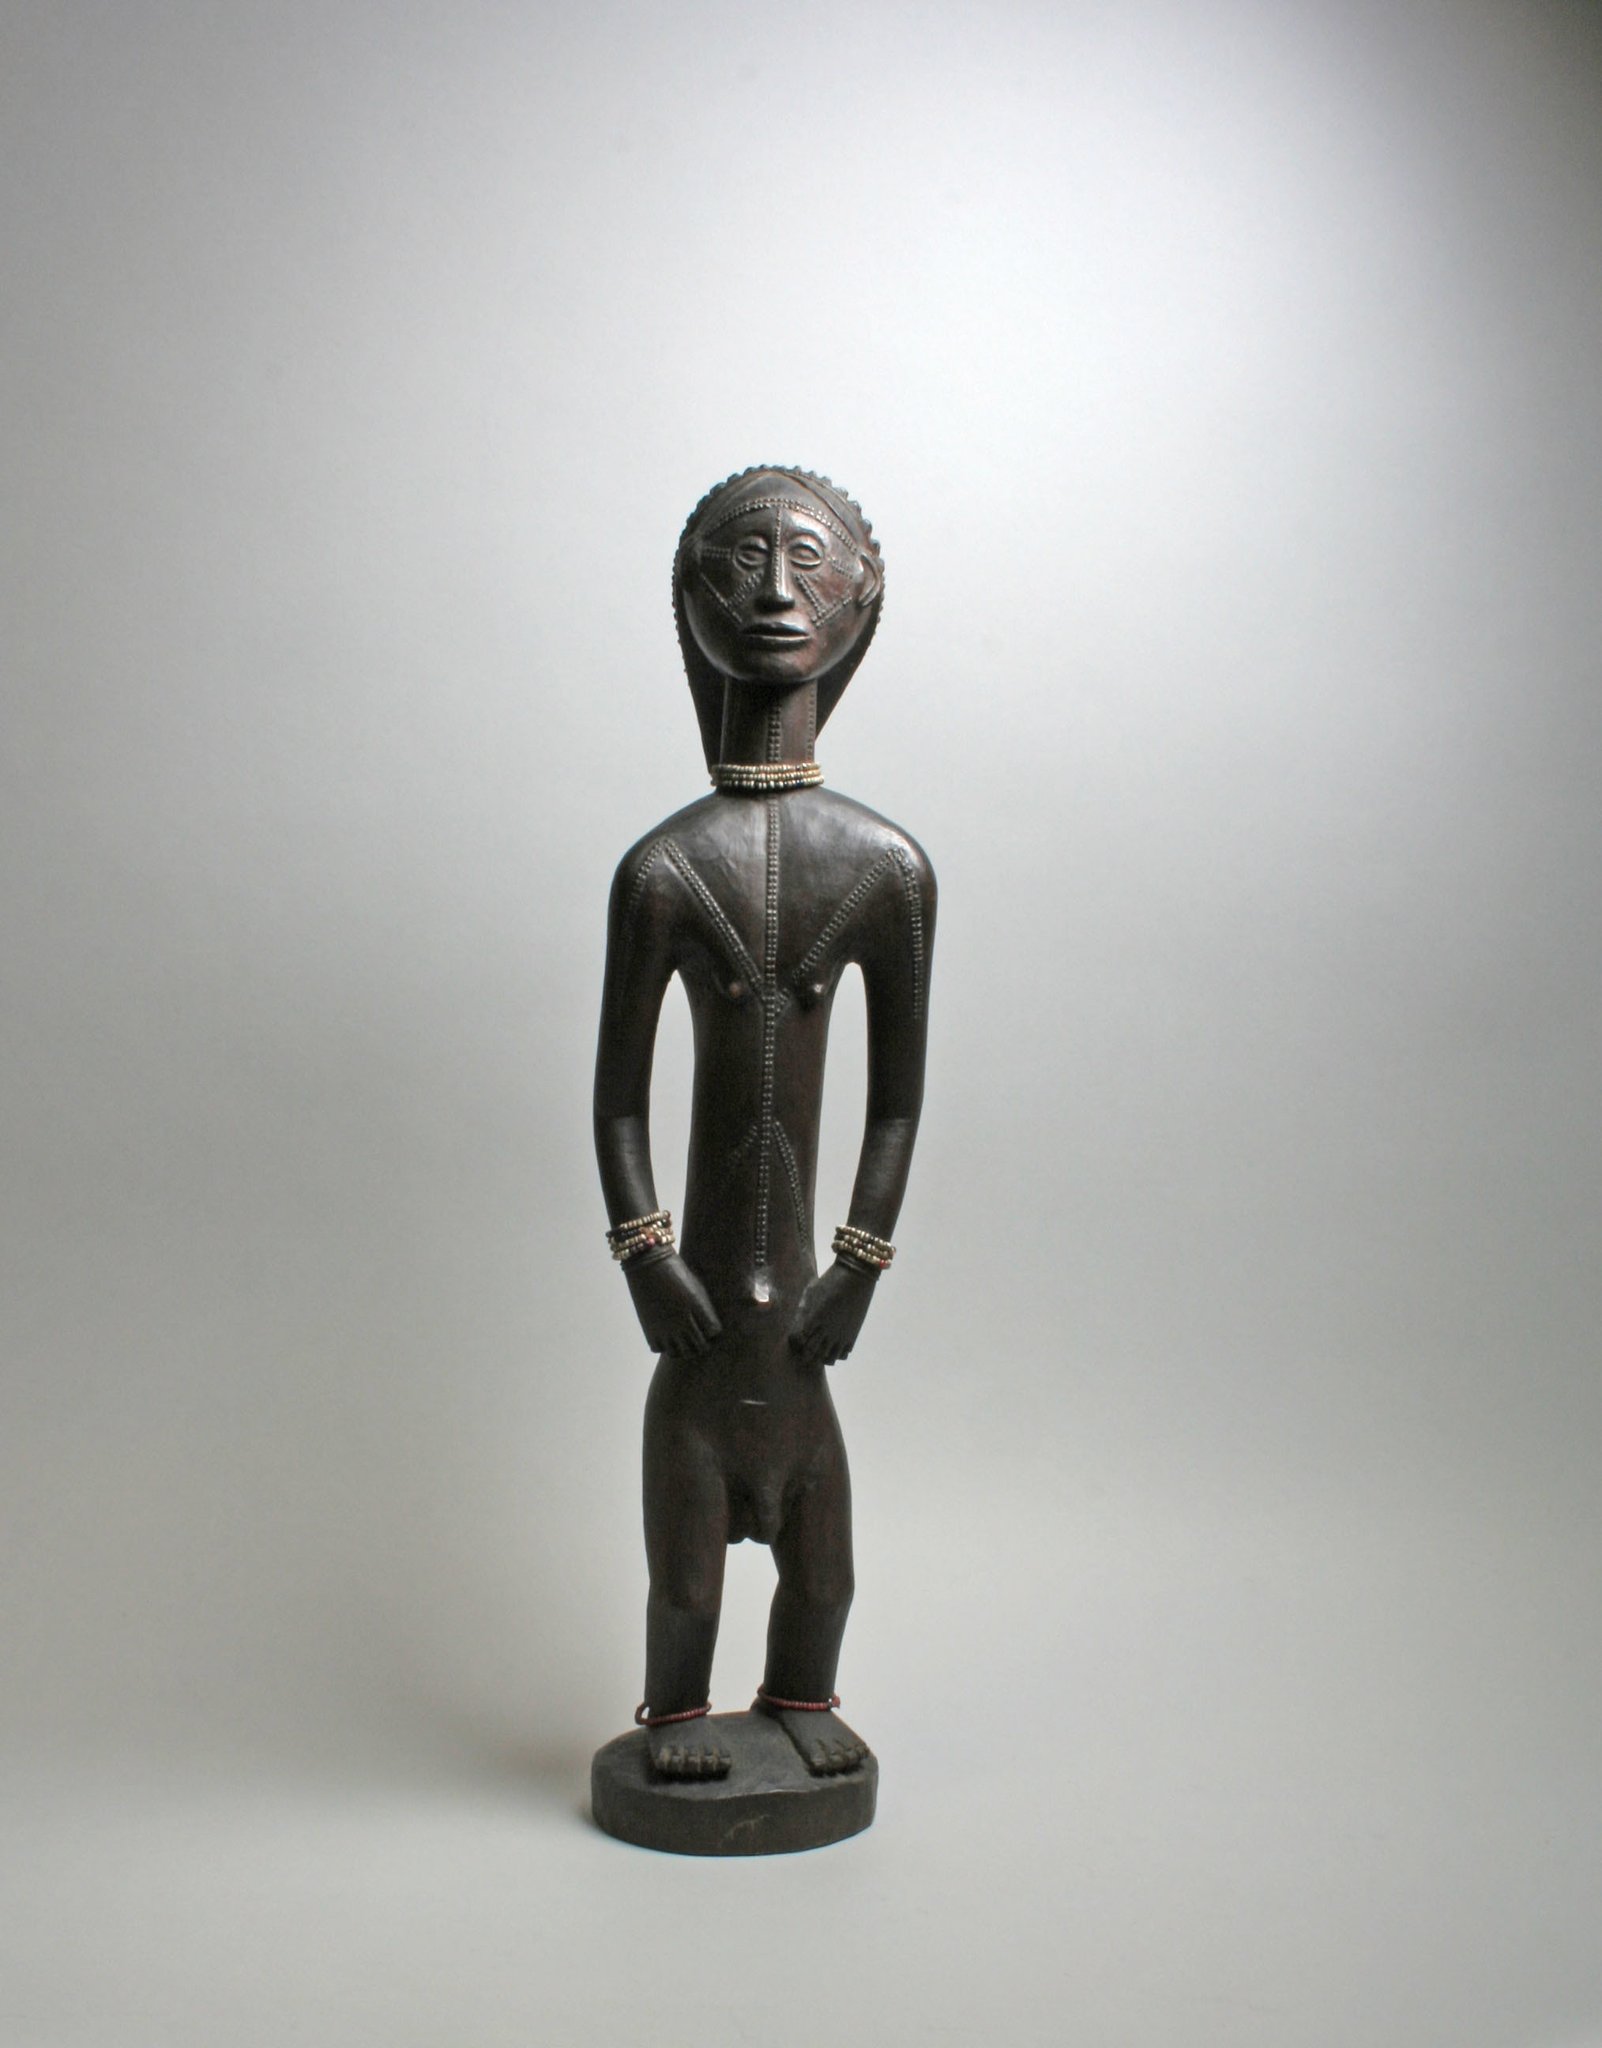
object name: male figure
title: Mukisi Mupasi (ancestor figure)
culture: tabwa peoples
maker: tabwa artist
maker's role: artist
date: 1834-1866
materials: cord, glass, wood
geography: democratic republic of the congo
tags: men